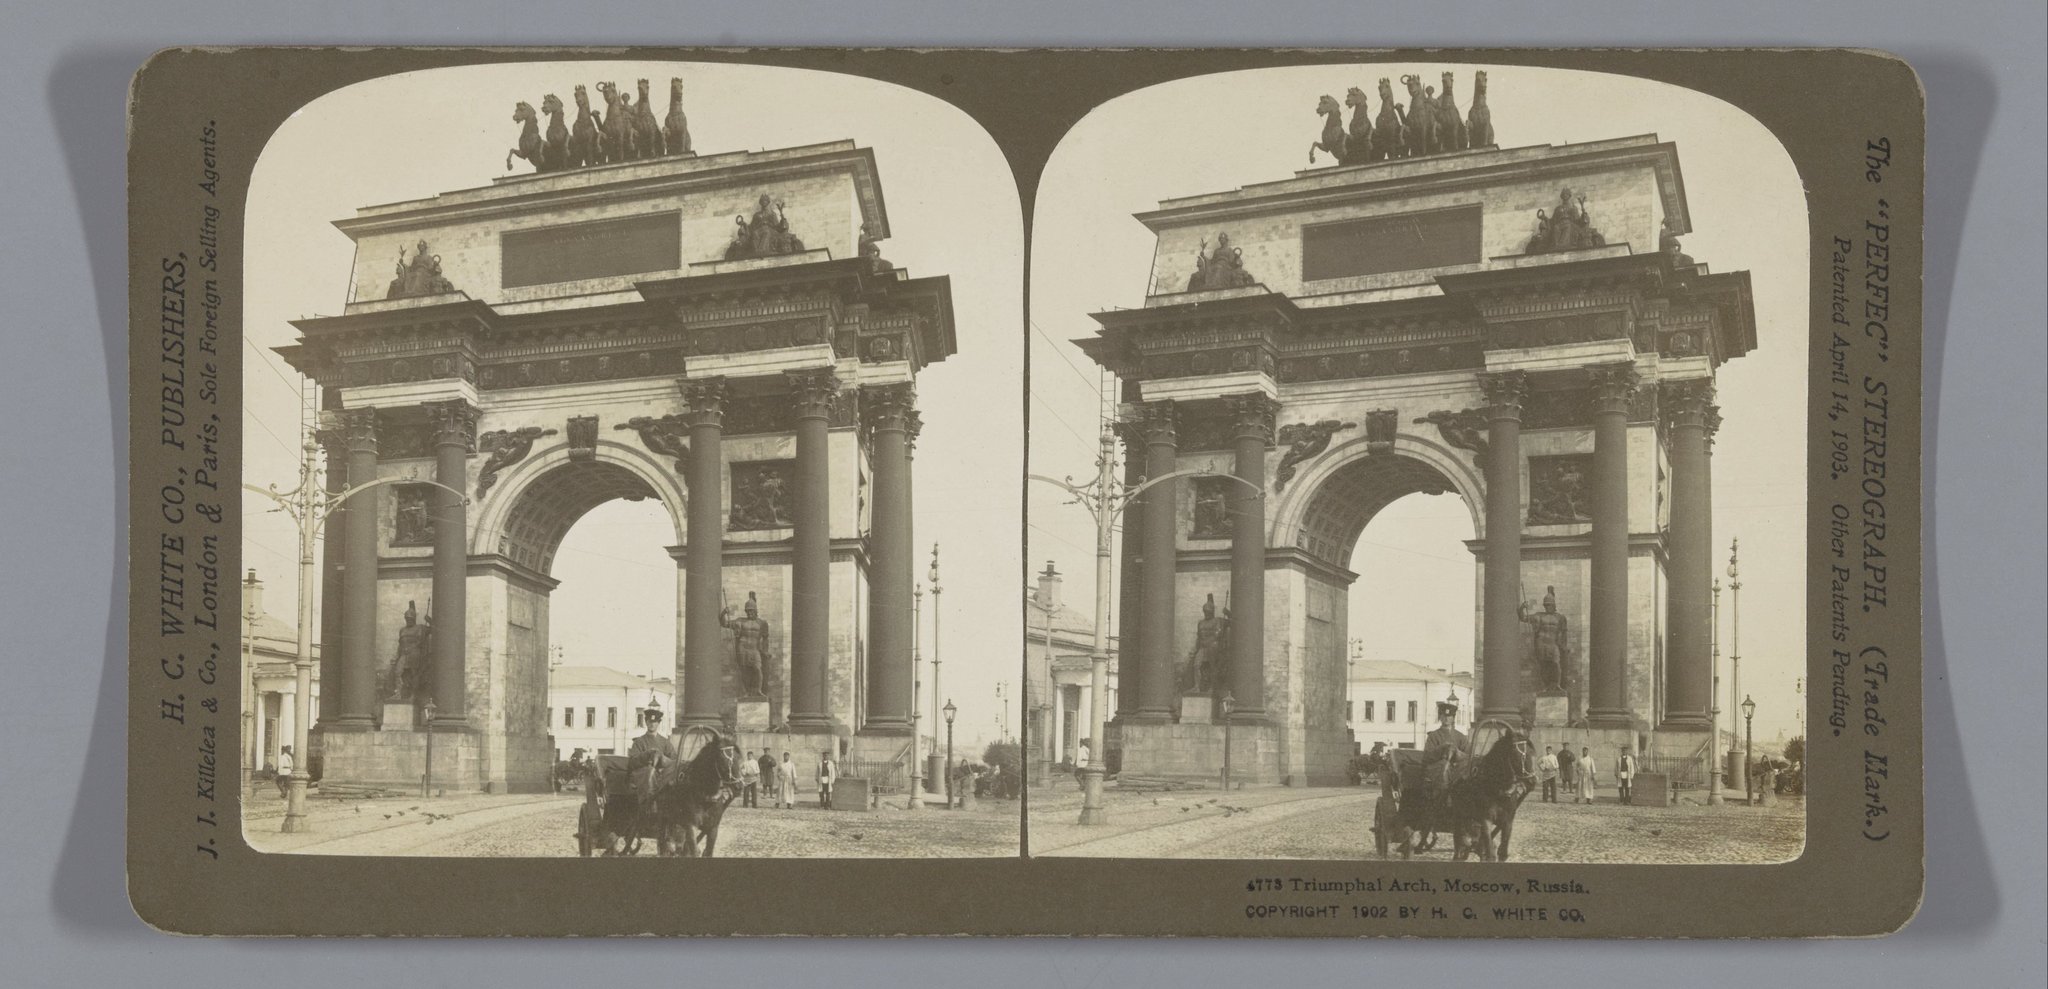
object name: stereograph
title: Triumphal Arch, Moscow, Russia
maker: Anonymous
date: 1902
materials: cardboard, photographic support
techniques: gelatin silver print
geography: moscow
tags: triumphal arch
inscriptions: name: ‘H. C. WHITE CO., PUBLISHERS, J J. Killelea & Co., London & Paris, Sole Foreign Selling Agents.’, inscription: ‘The "Perfec" Stereograph. (Trade Mark.) Patented April 14, 1903. Other Patents Pending.’, number: ‘4775’